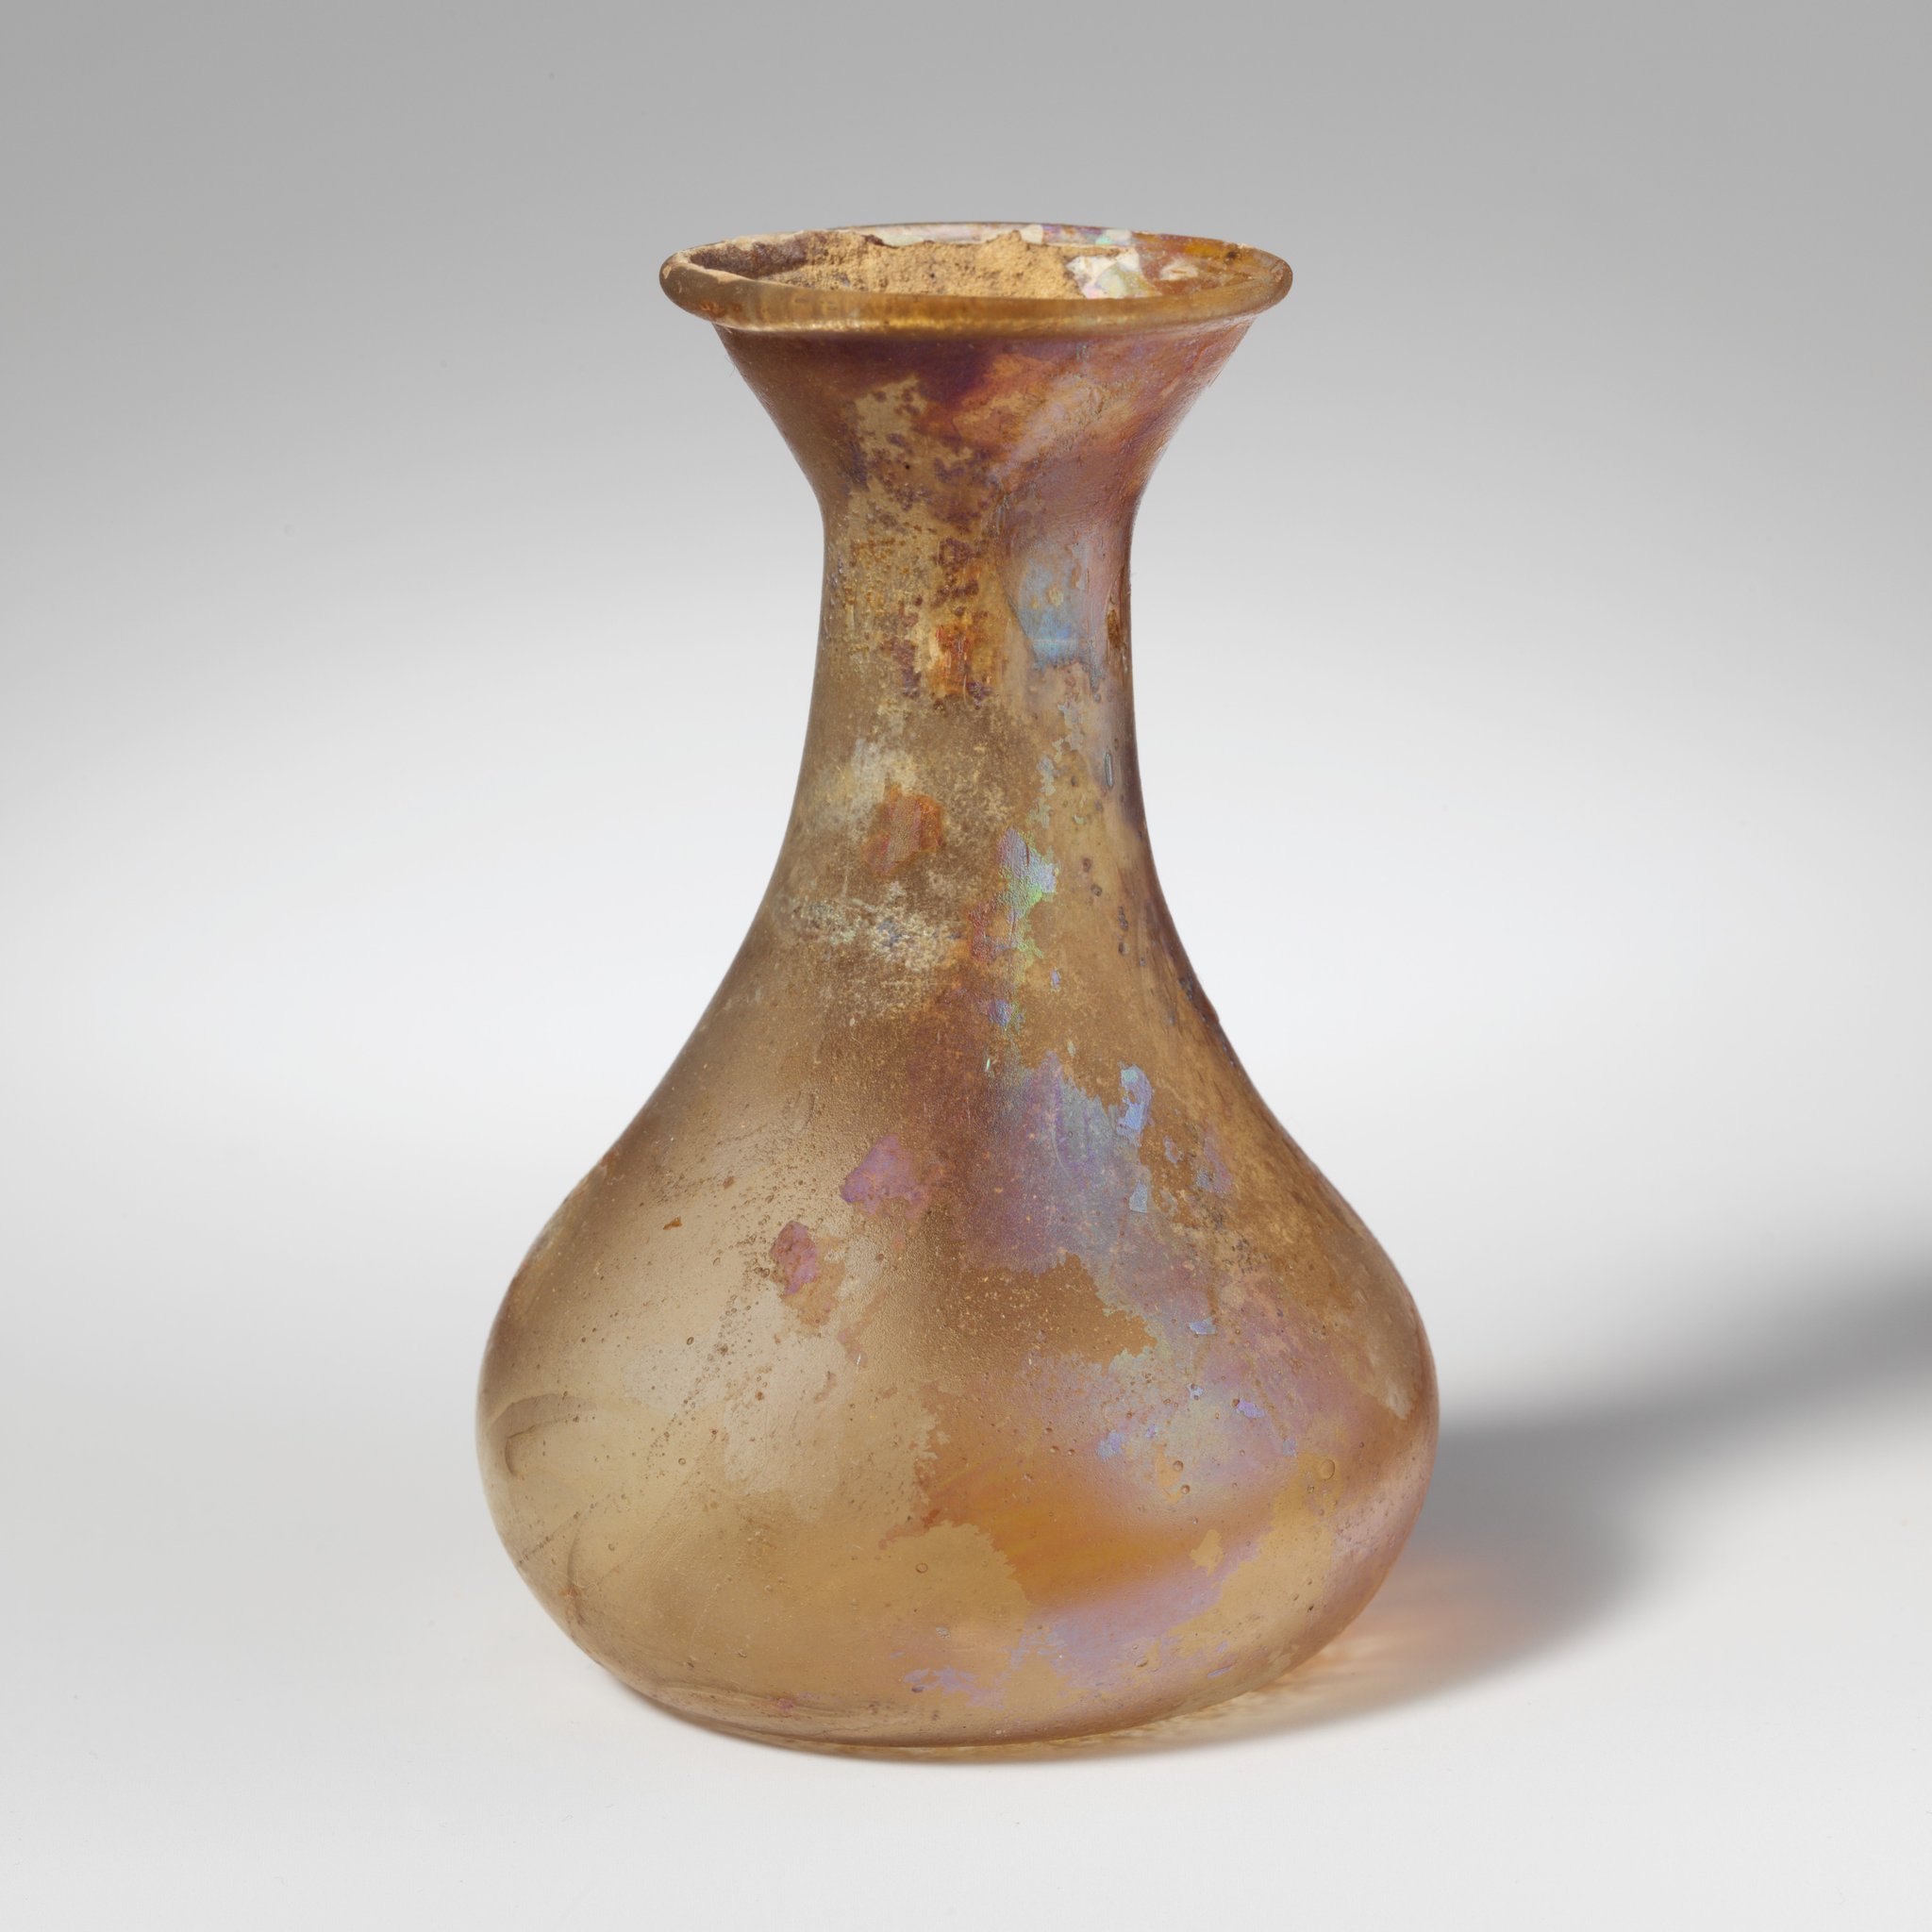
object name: flask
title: Glass flask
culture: roman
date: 101-300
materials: glass